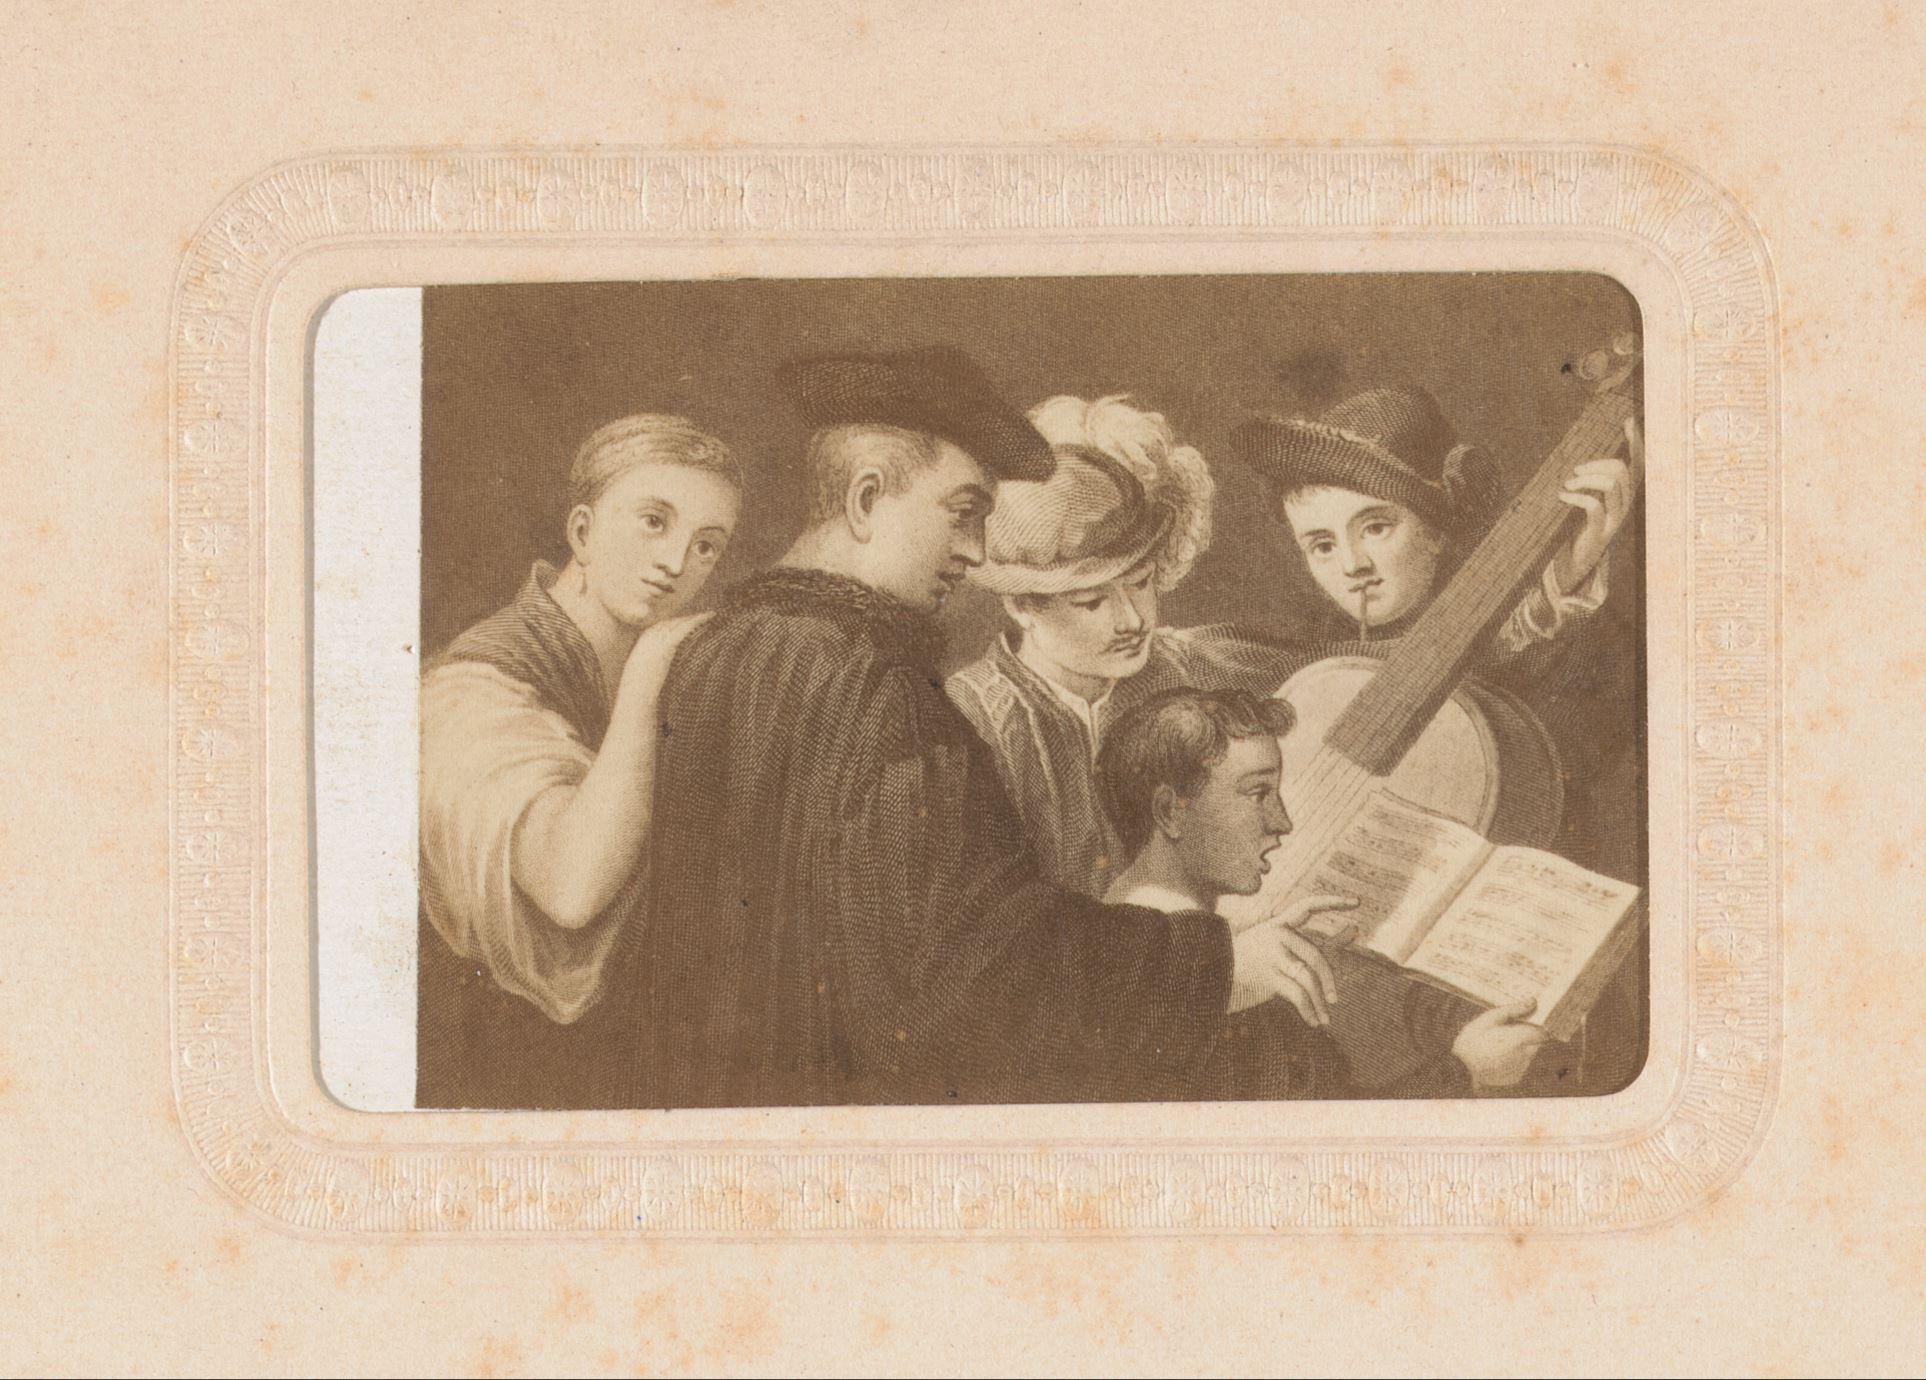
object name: album leaf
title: Fotoreproductie van een schilderij met een musicerend gezelschap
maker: Anonymous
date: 1855-1865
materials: cardboard, photographic support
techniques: albumen print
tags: making music; musician with instrument, vocal music, singing